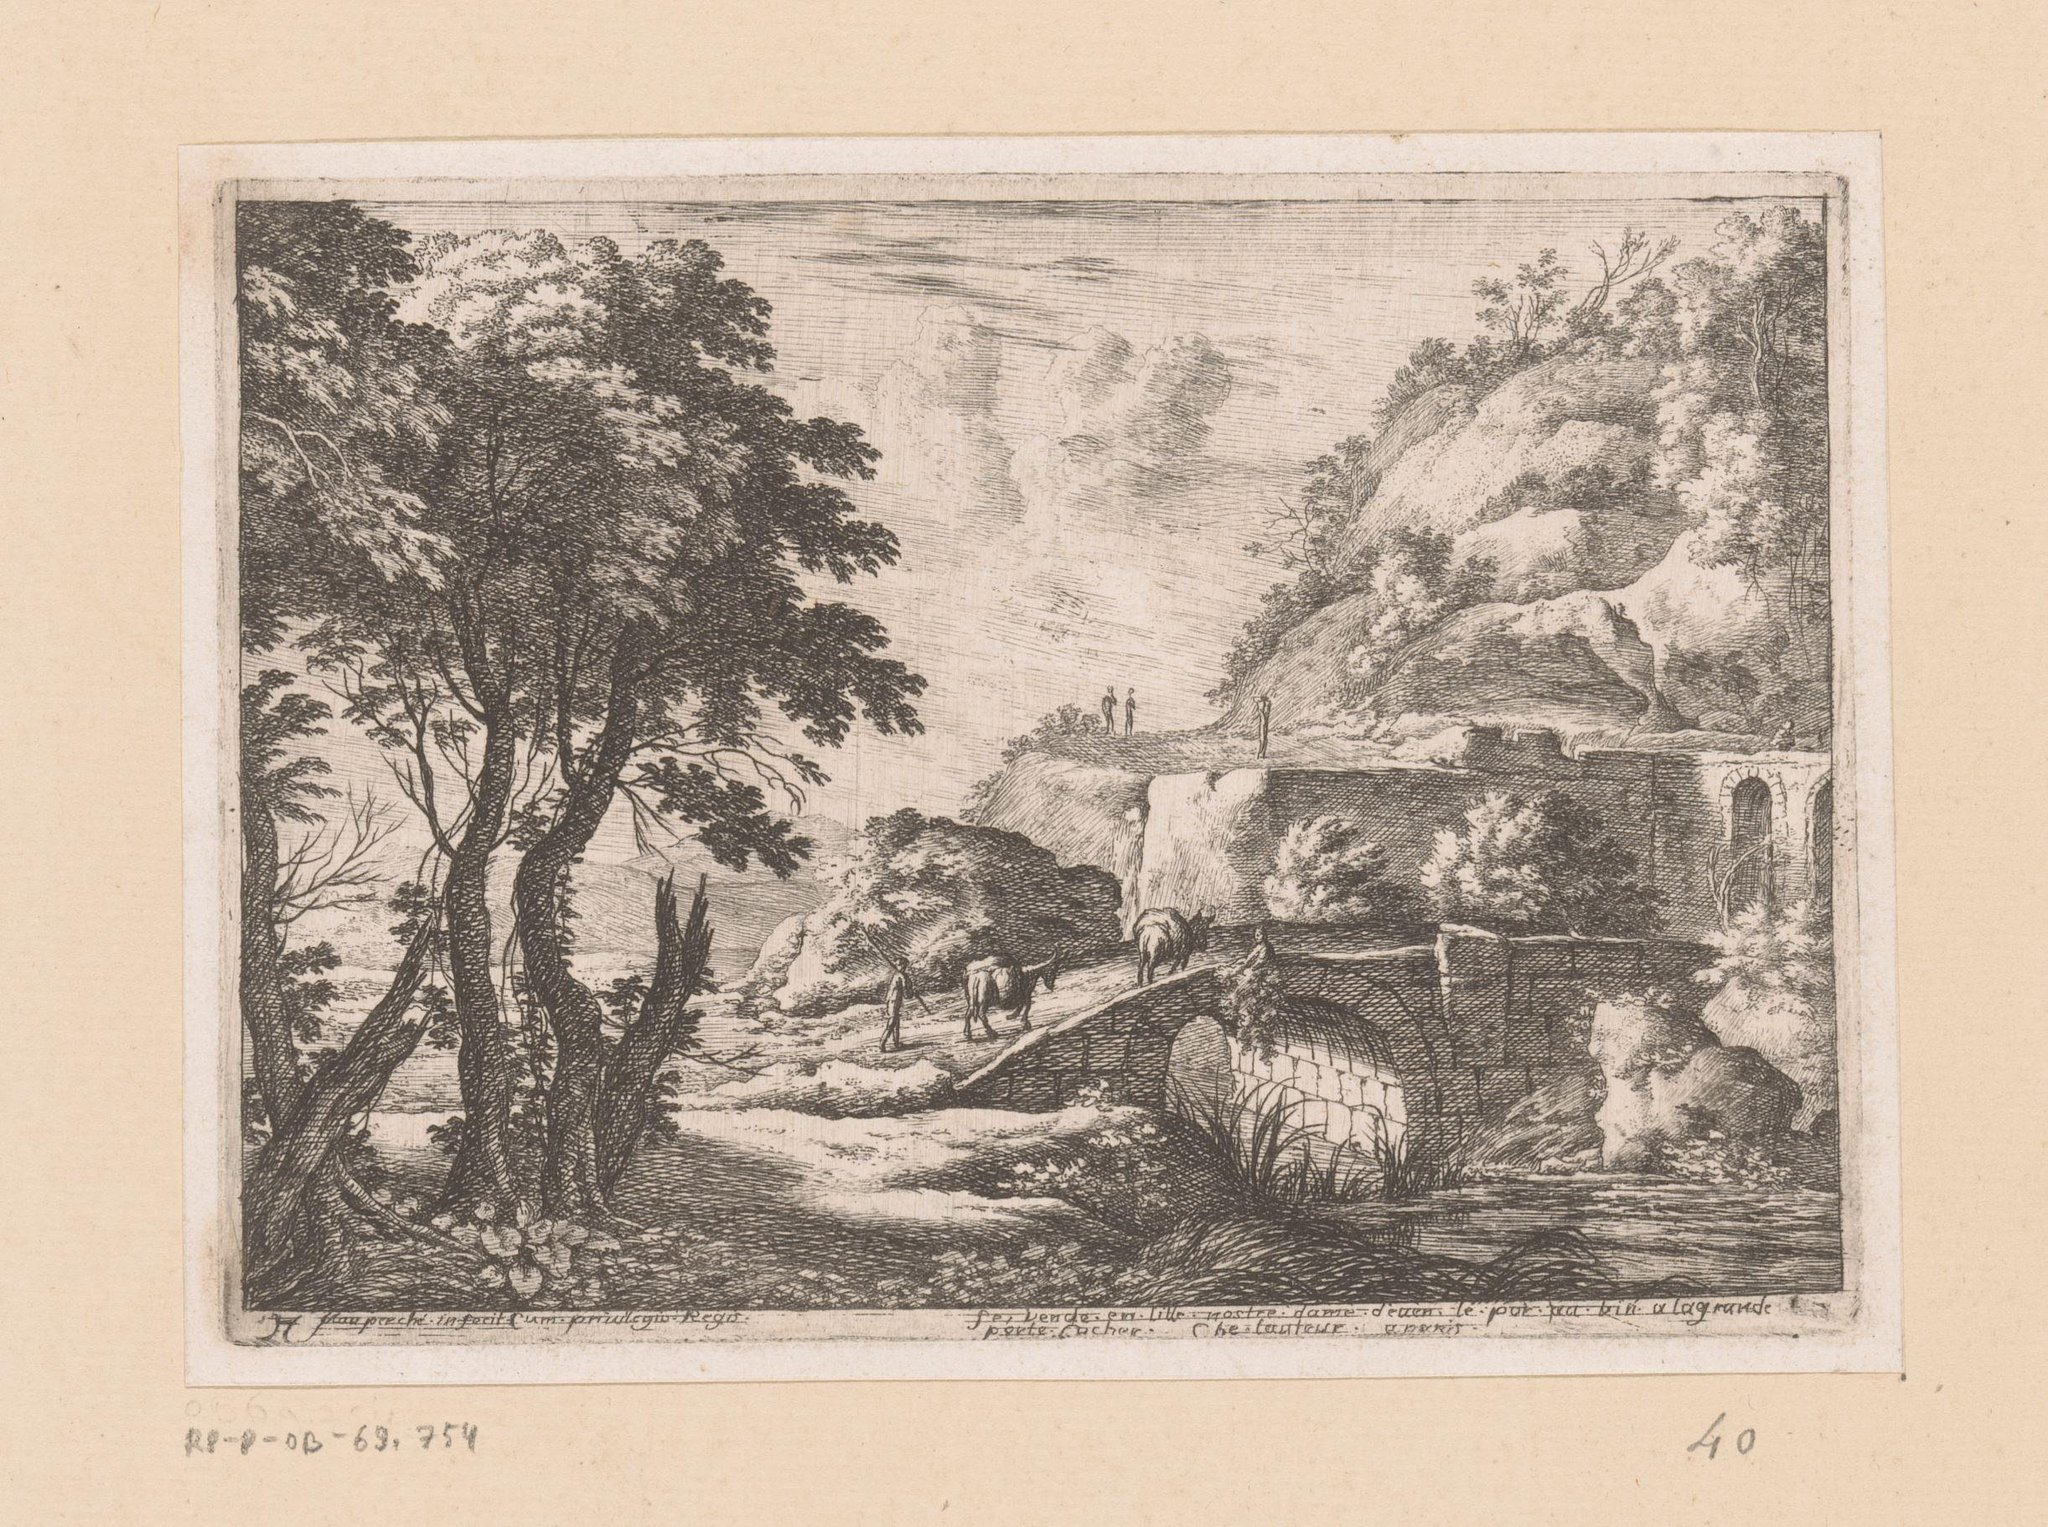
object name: print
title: Landschap met stenen brug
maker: henri mauperché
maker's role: painter, print maker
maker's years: 1602-1686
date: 1612-1686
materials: paper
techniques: etching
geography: france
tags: (high) hill, bridge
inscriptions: collector's mark: Lugt 240